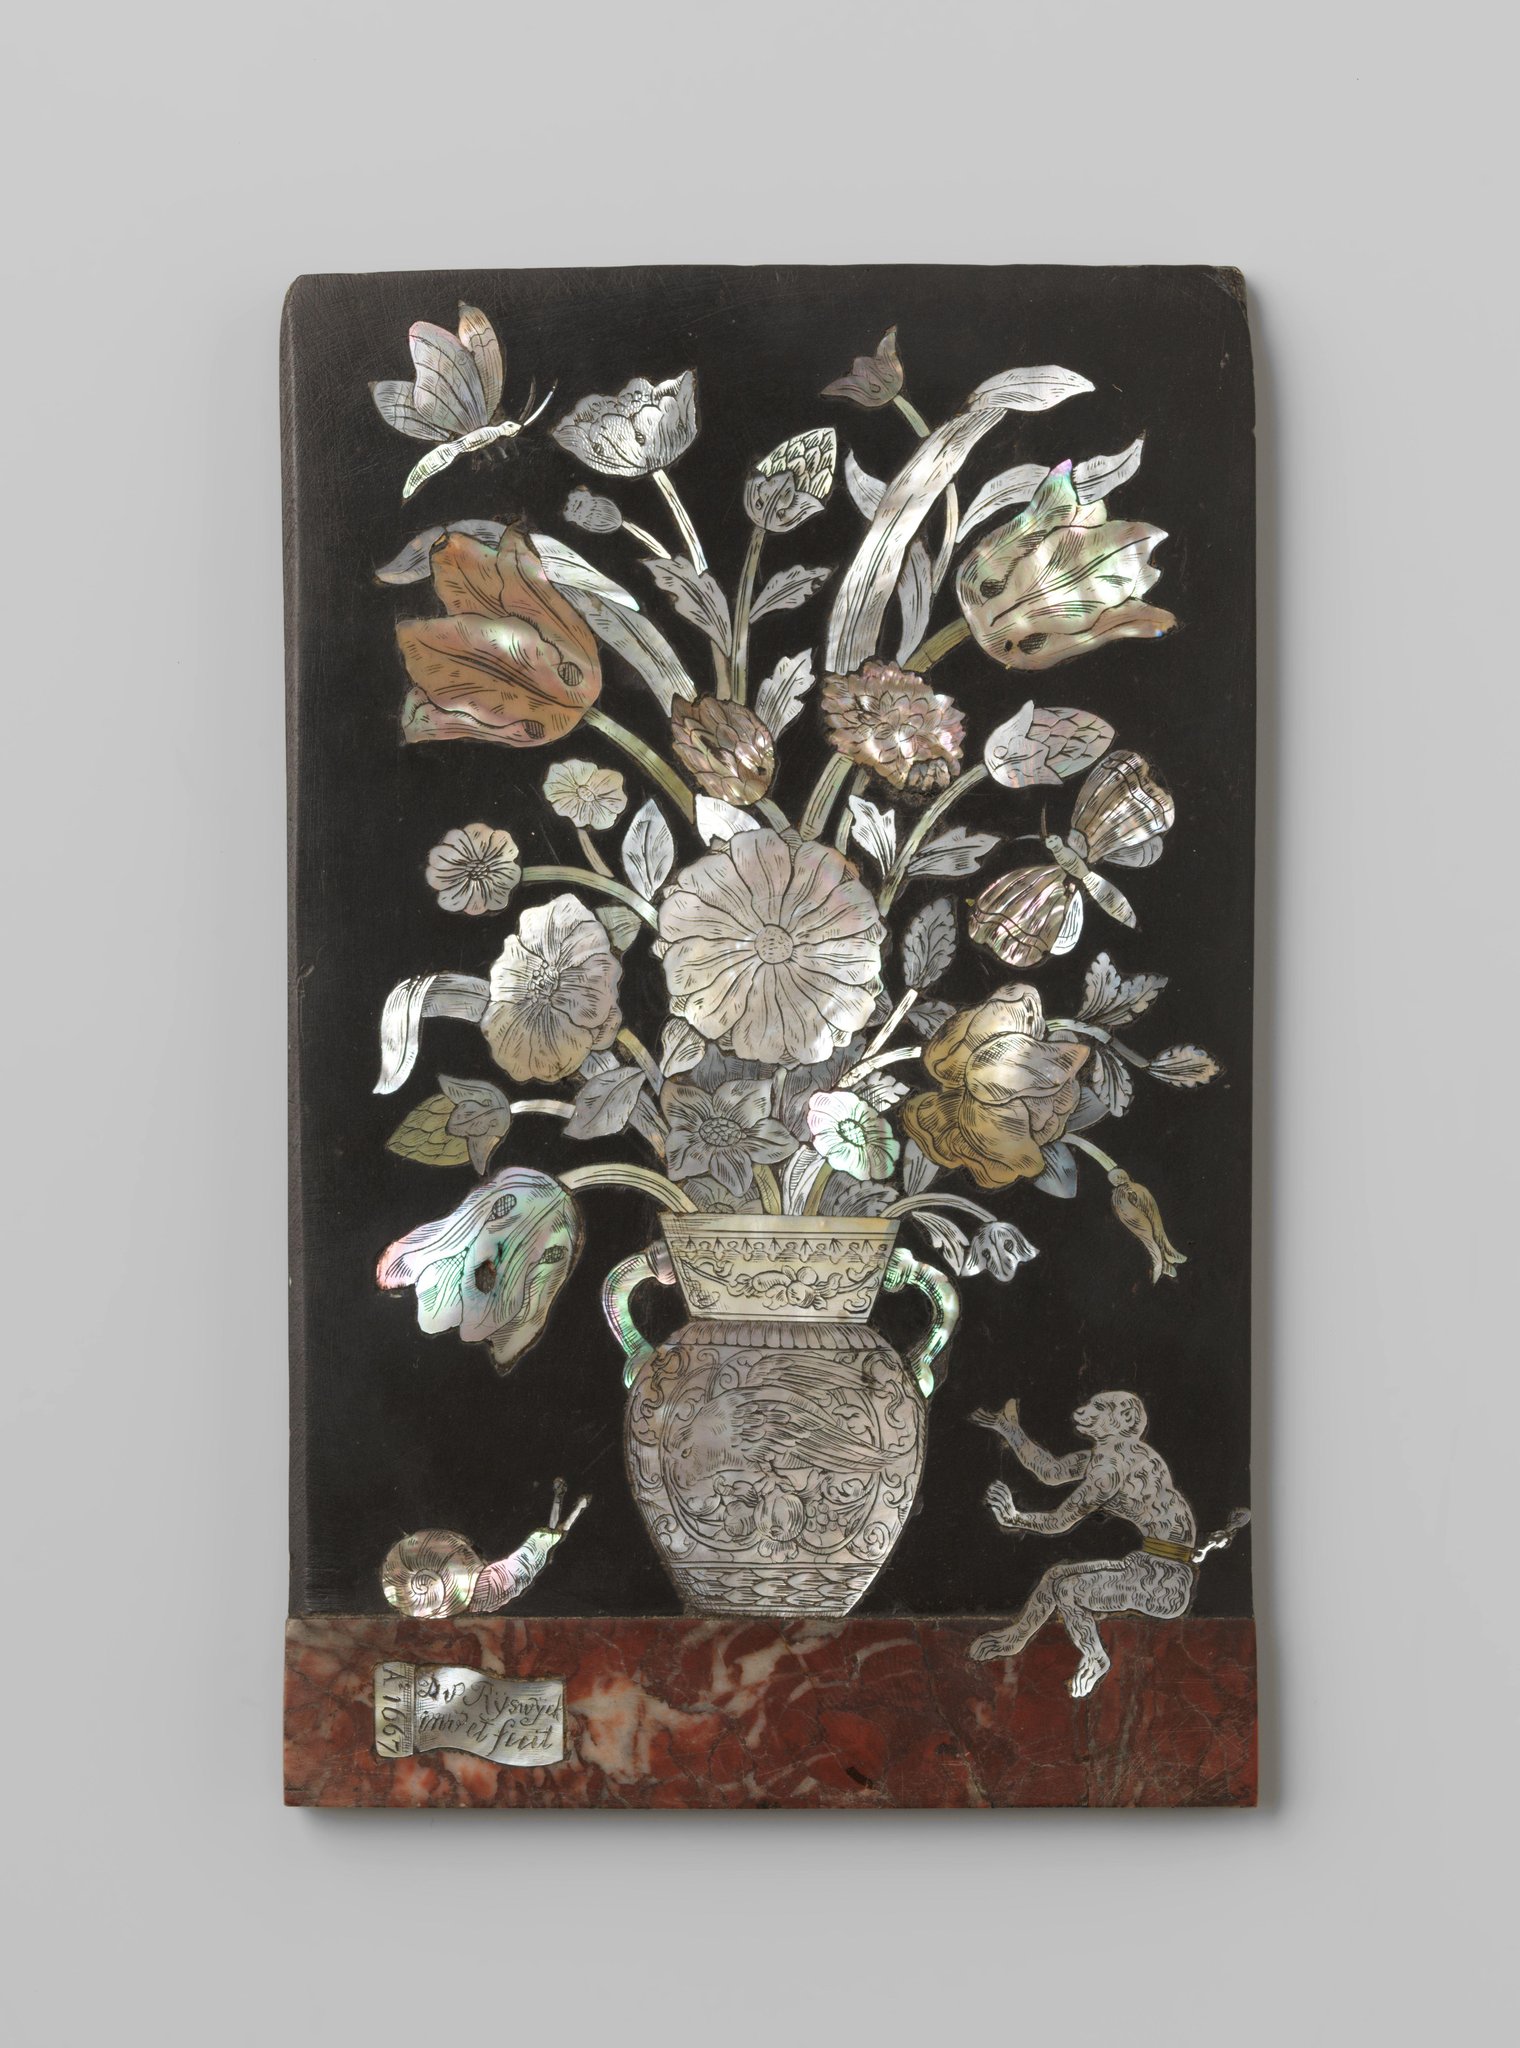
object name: panel ornament area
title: Paneel met ingelegde voorstelling van een vaas met bloemen, een aap en een slak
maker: dirk van rijswijck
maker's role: medailleur, paarlemoerinlegger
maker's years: 1596-1679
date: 1667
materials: glass, marble, mother of pearl, stone, wood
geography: amsterdam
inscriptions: signature and date: ‘D V Rijswijck // inv et fecit // Ao 1667’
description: Paneel van toeststeen (zwart marmer ?), ingelegd met parelmoer en marmer. Het paneel vertoont een vaas met bloemen, waarvoor een aap en een slak. Het paneel is getekend: "D V Ryswyck inv. et fecit anno 1667". Het paneel bevindt zich in een zwarte lijst achter glas.